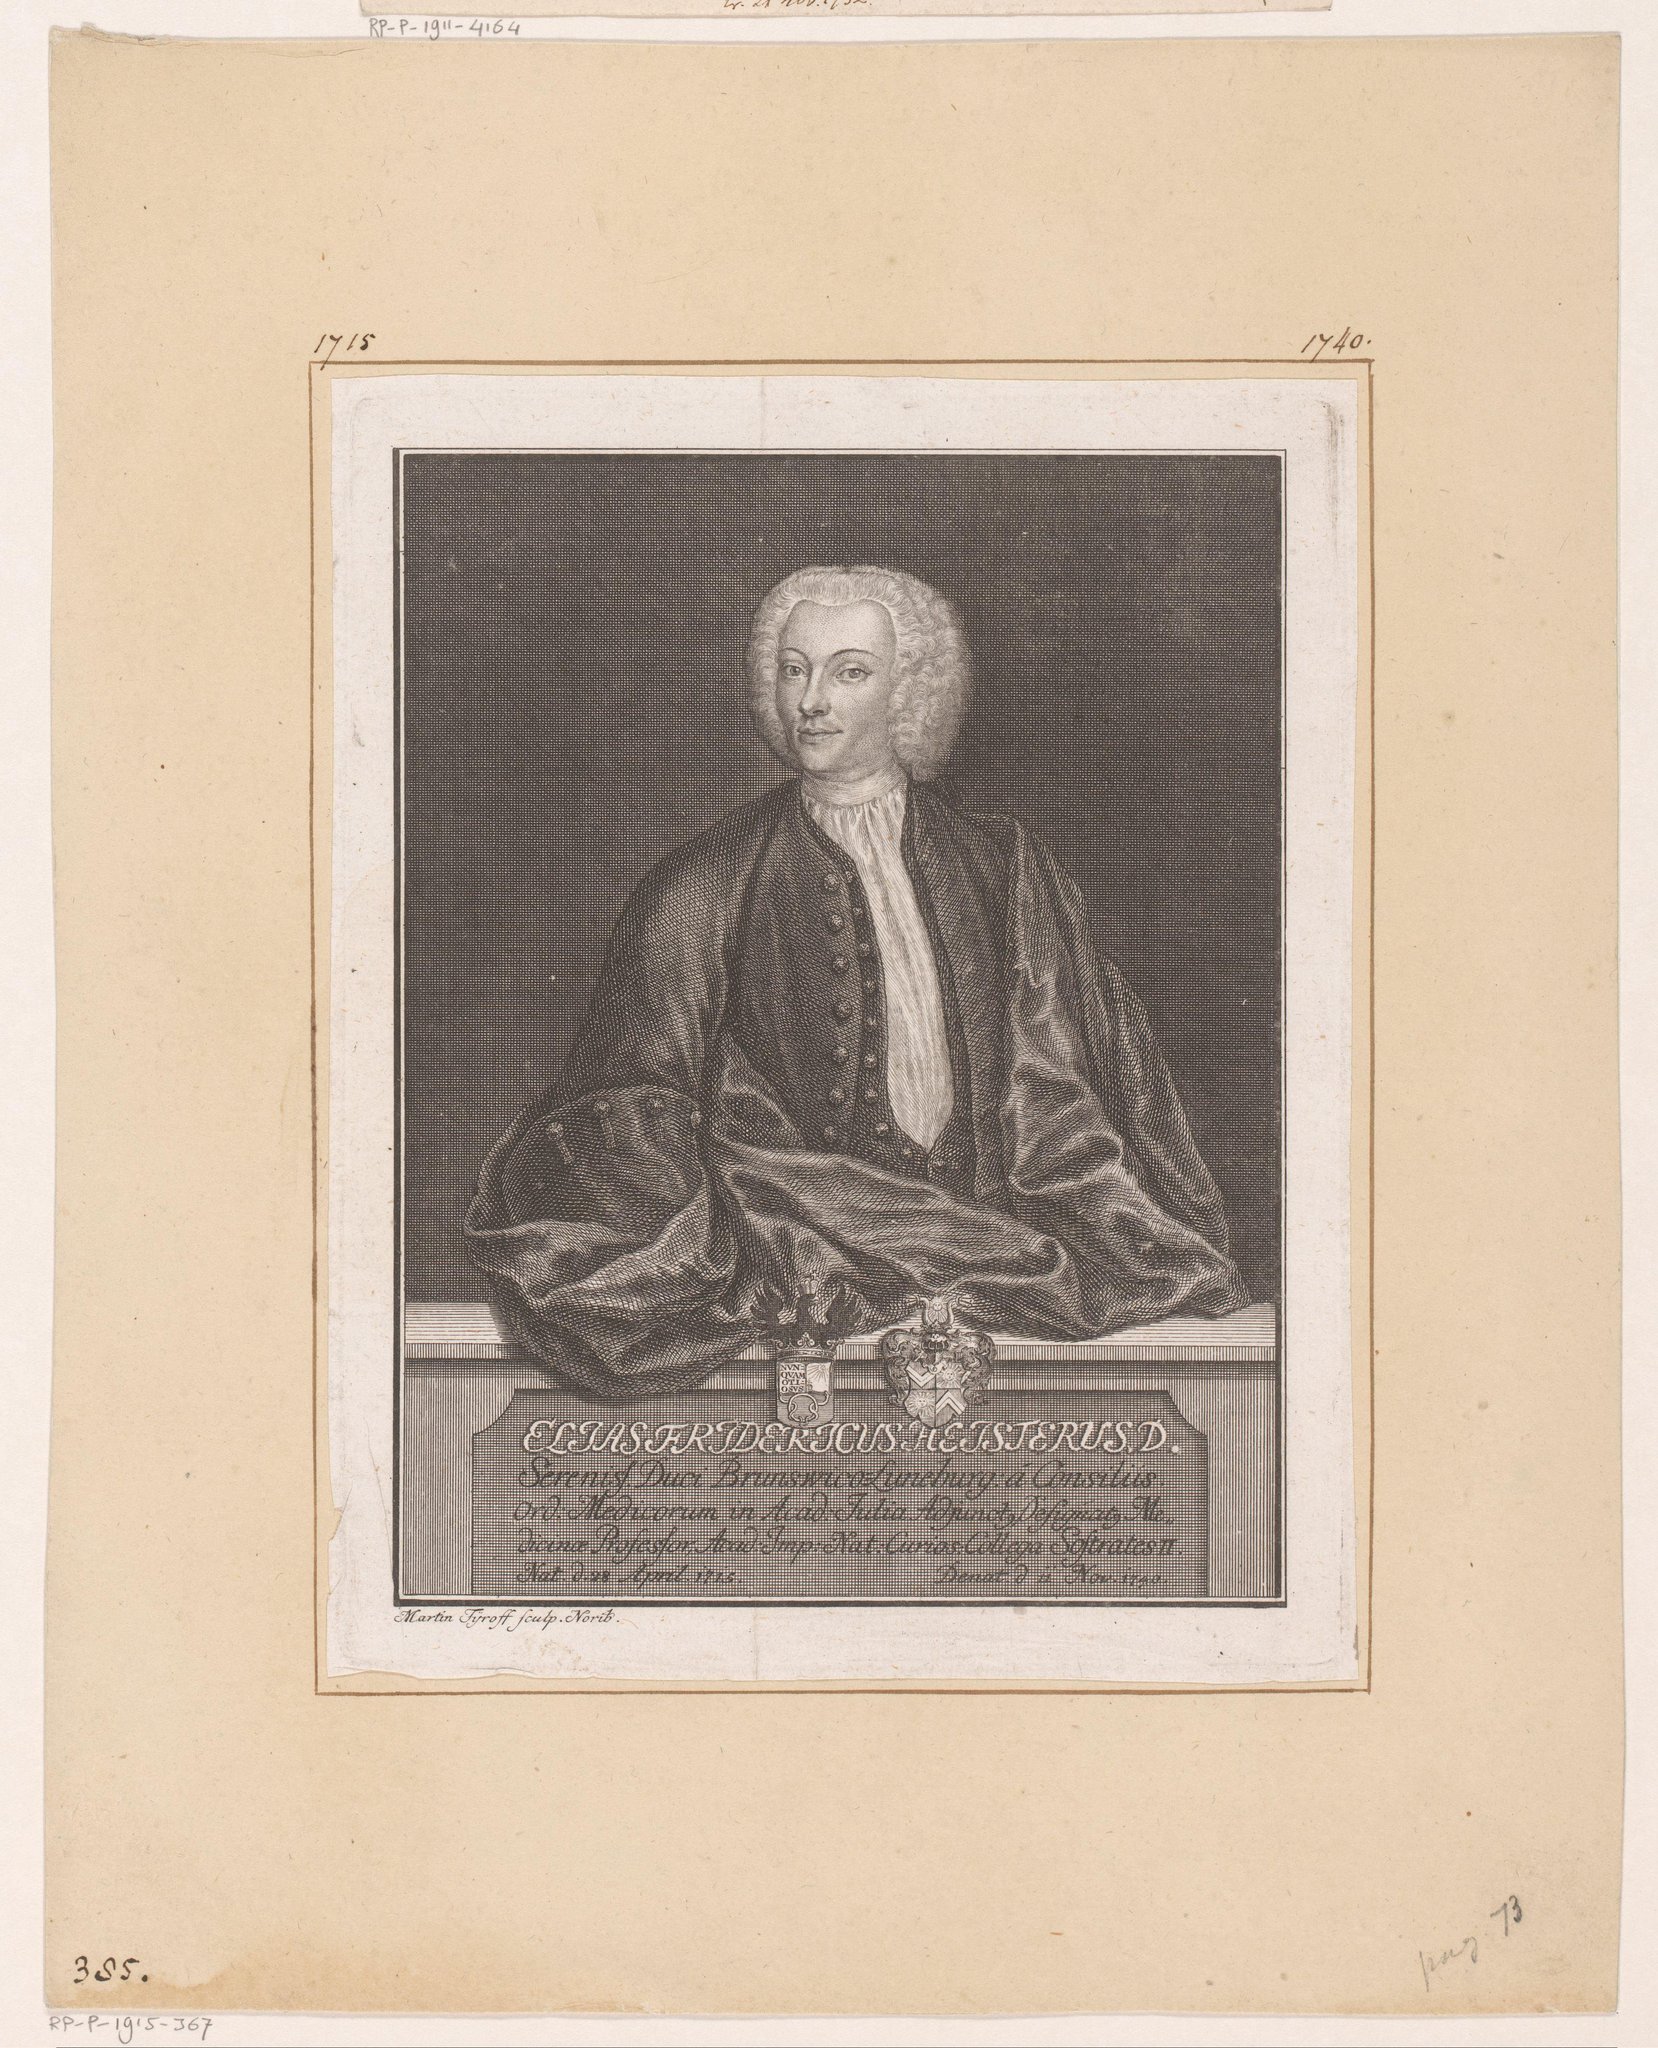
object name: print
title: Portret van Elias Friedrich Heister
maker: martin tyroff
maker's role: print maker, publisher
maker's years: 1704-1779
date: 1740-1779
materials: paper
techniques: engraving, etching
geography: nuremberg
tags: leiden, historical persons, armorial bearing, heraldry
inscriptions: number: ‘385’, collector's mark: Lugt 2228